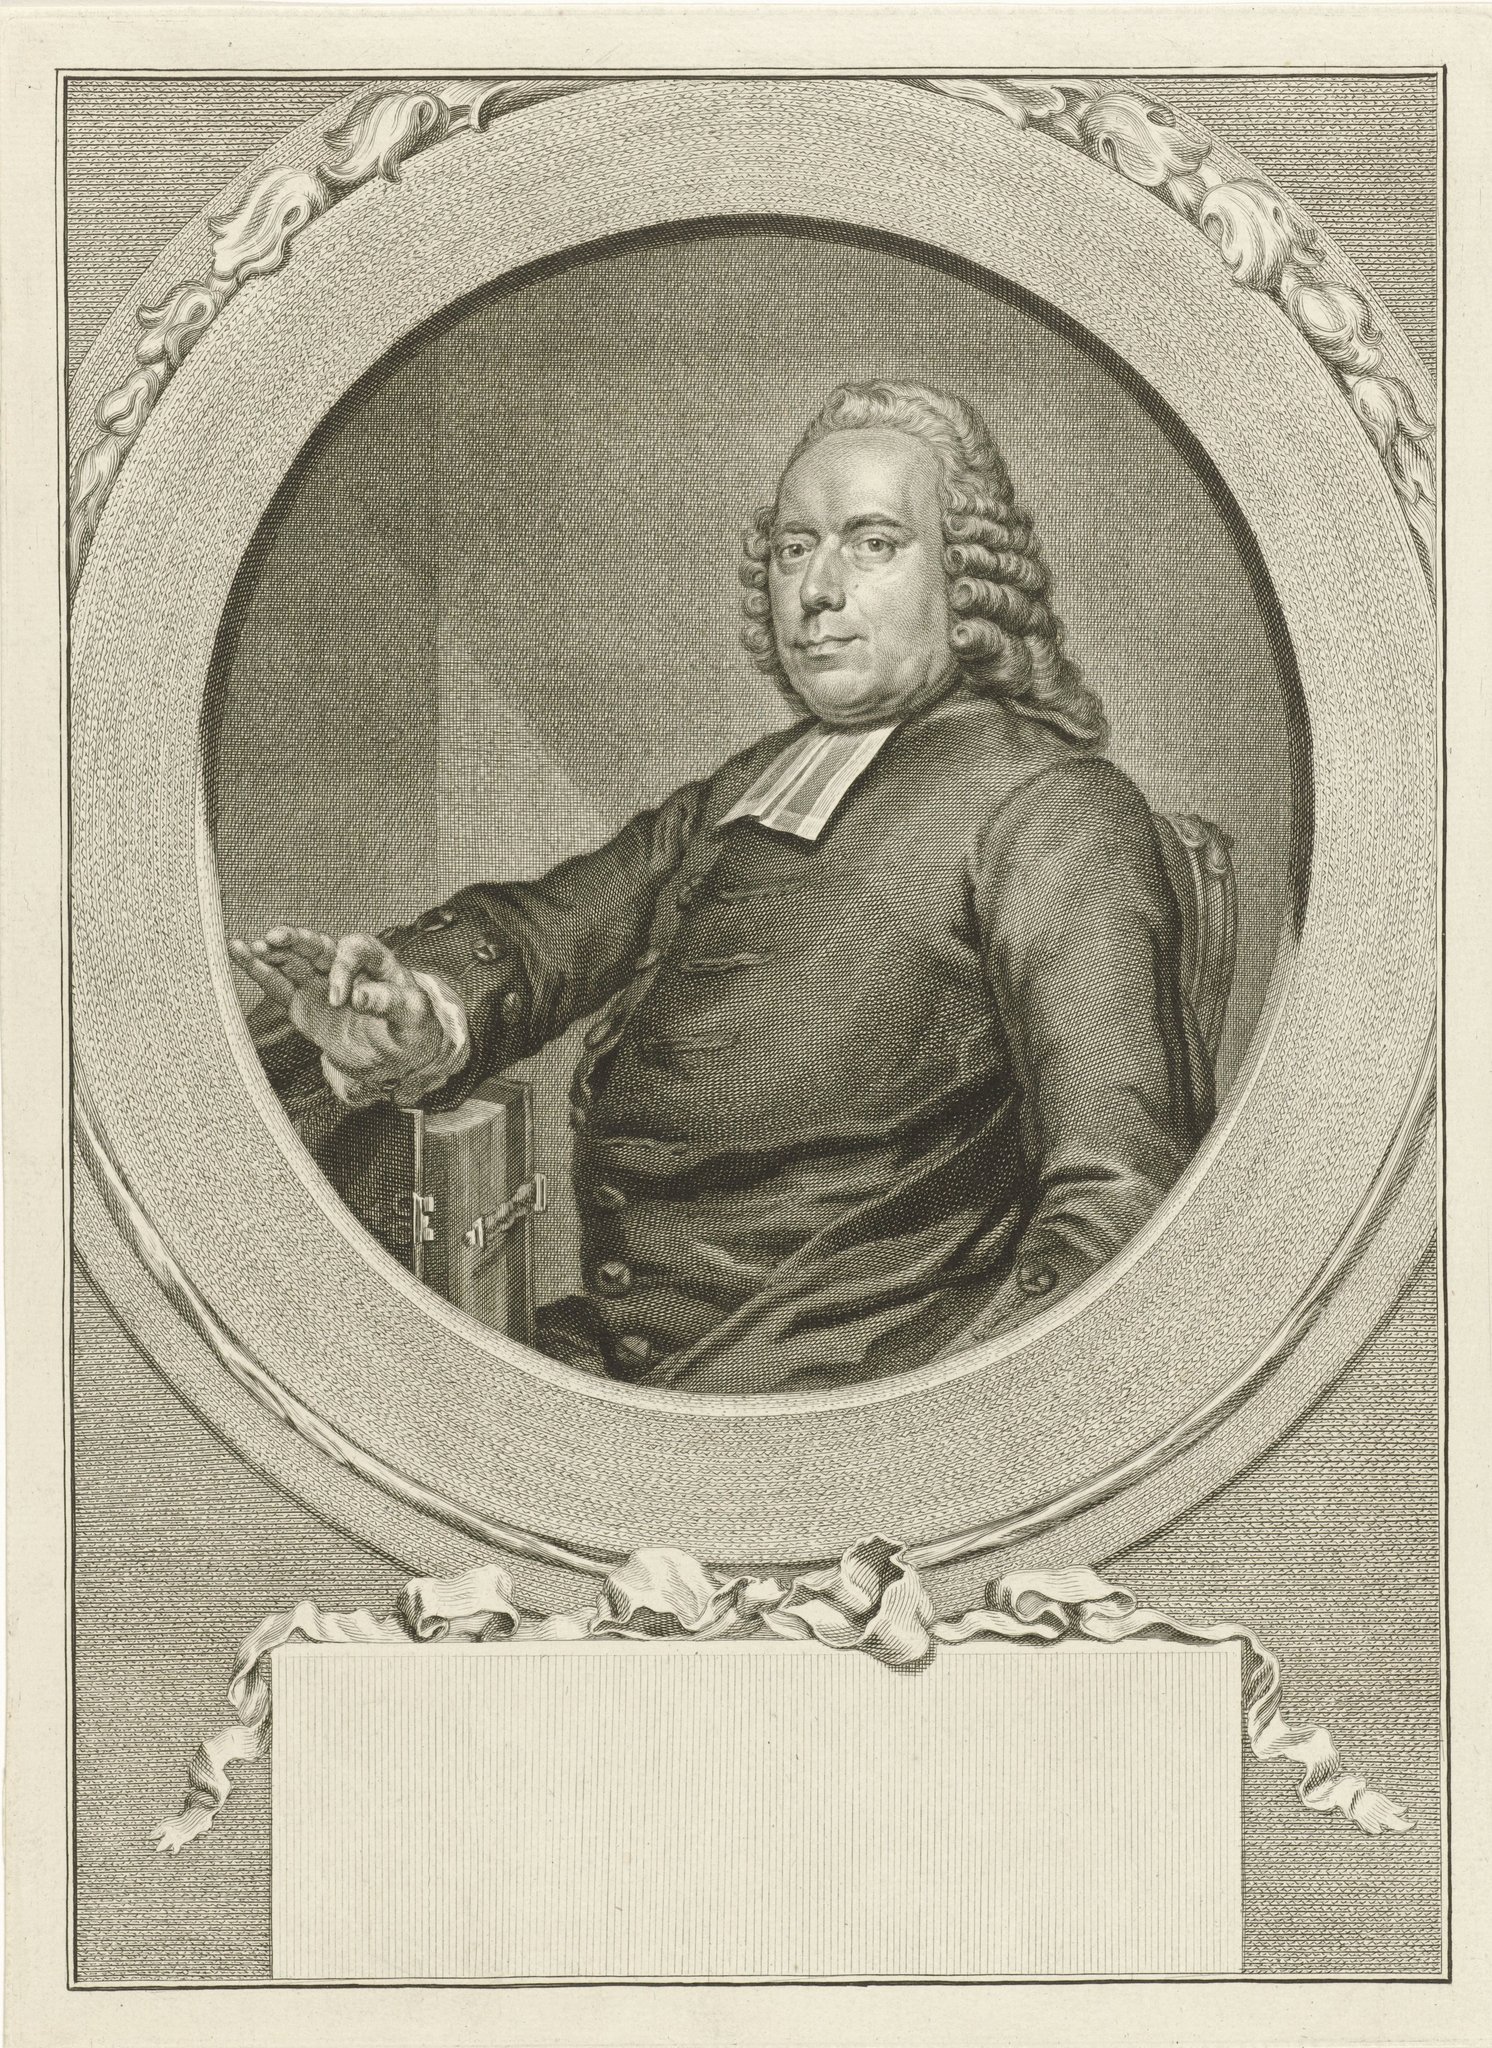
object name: print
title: Portret van Ernestus Philippus Gerhardus van Essen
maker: jacob houbraken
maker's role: draughtsman, print maker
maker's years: 1698-1780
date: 1771-1772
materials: paper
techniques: engraving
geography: amsterdam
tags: the bible as a book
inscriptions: collector's mark: Lugt 2228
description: Portret ten halven lijve naar links van Ernestus Philippus Gerhardus van Essen in een medaillon, zittend op een stoel en met zijn rechterarm rustend op een bijbel. Onder het medaillon een leeg veld voor zijn naam en gegevens.